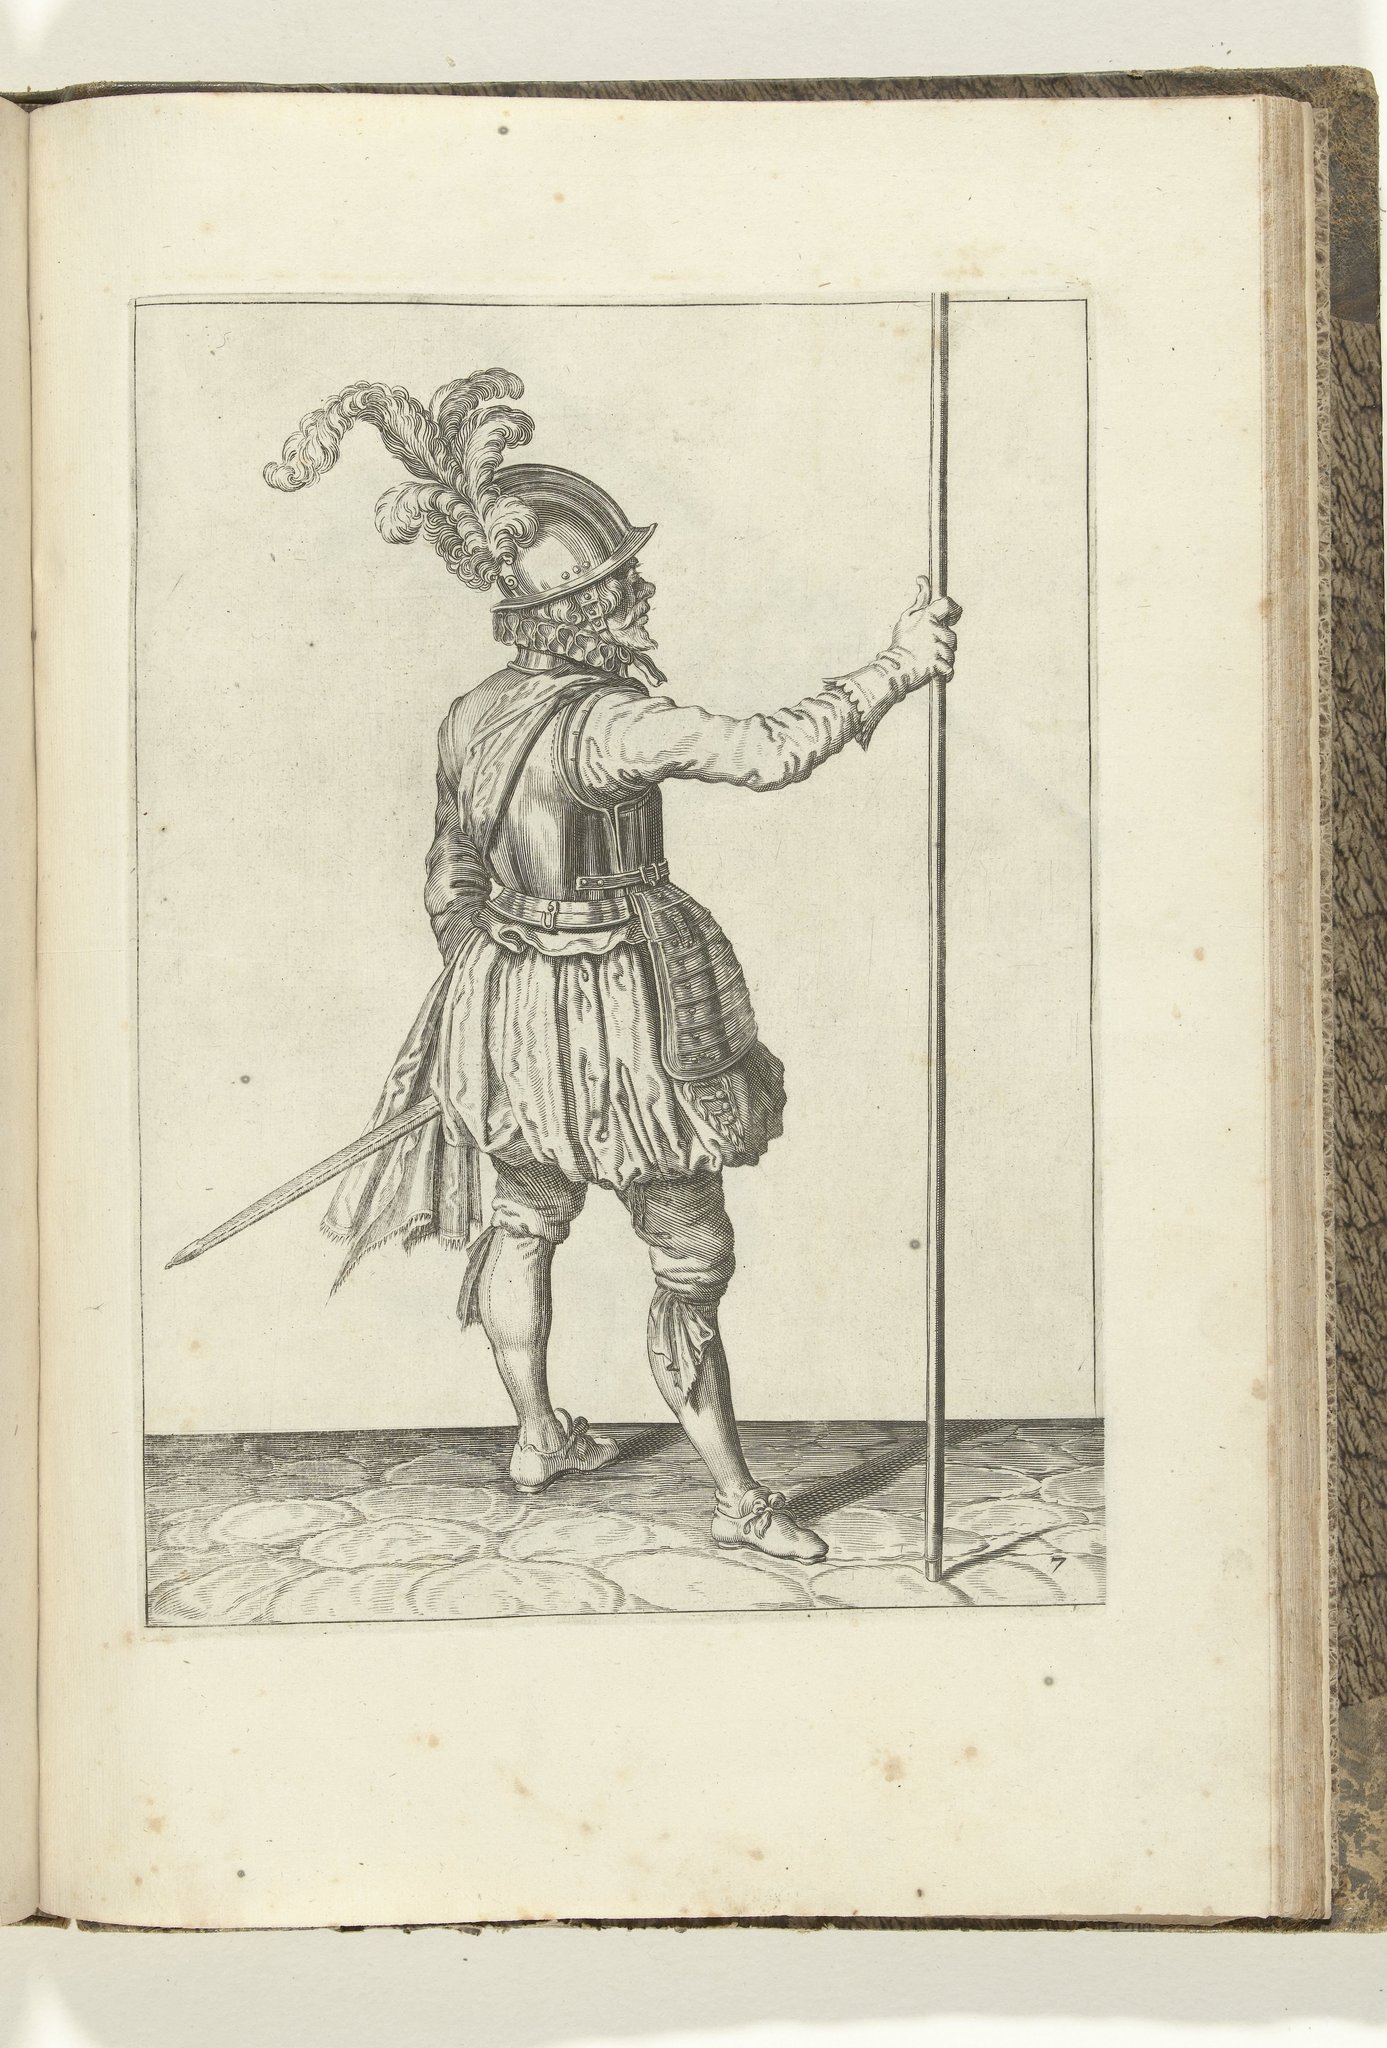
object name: print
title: Soldaat, op de rug gezien, die zijn spies met zijn rechterhand rechtop vasthoudt (nr. 7), ca. 1600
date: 1597-1608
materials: paper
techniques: engraving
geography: northern netherlands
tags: maurice (prince of orange), handling of weapons ~ military training, weapons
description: Een soldaat, ten voeten uit, op de rug gezien, die een spies (lans) met zijn rechterhand rechtop vasthoudt (nr. 7), ca. 1600. Dit is de derde handeling voor het rechtop naar de grond brengen van de spies. Plaat 7 in de instructies voor het hanteren van de spies: Enseignement brief; et succint sur les portraitz figurez, touchant l'usage, de tout ce qu'un Soldat doibt faire au maniement de la Pique. Onderdeel van de illustraties in een Franse editie van J. de Gheyns Wapenhandelinghe: J. de Gheyn, Maniement d'armes, d'arquebuses, mousquetz et piques : en conformité de l'ordre de Mour le Prince Maurice, Prince d'Orange, Amsterdam 1608. Krijgswezen rond 1600.